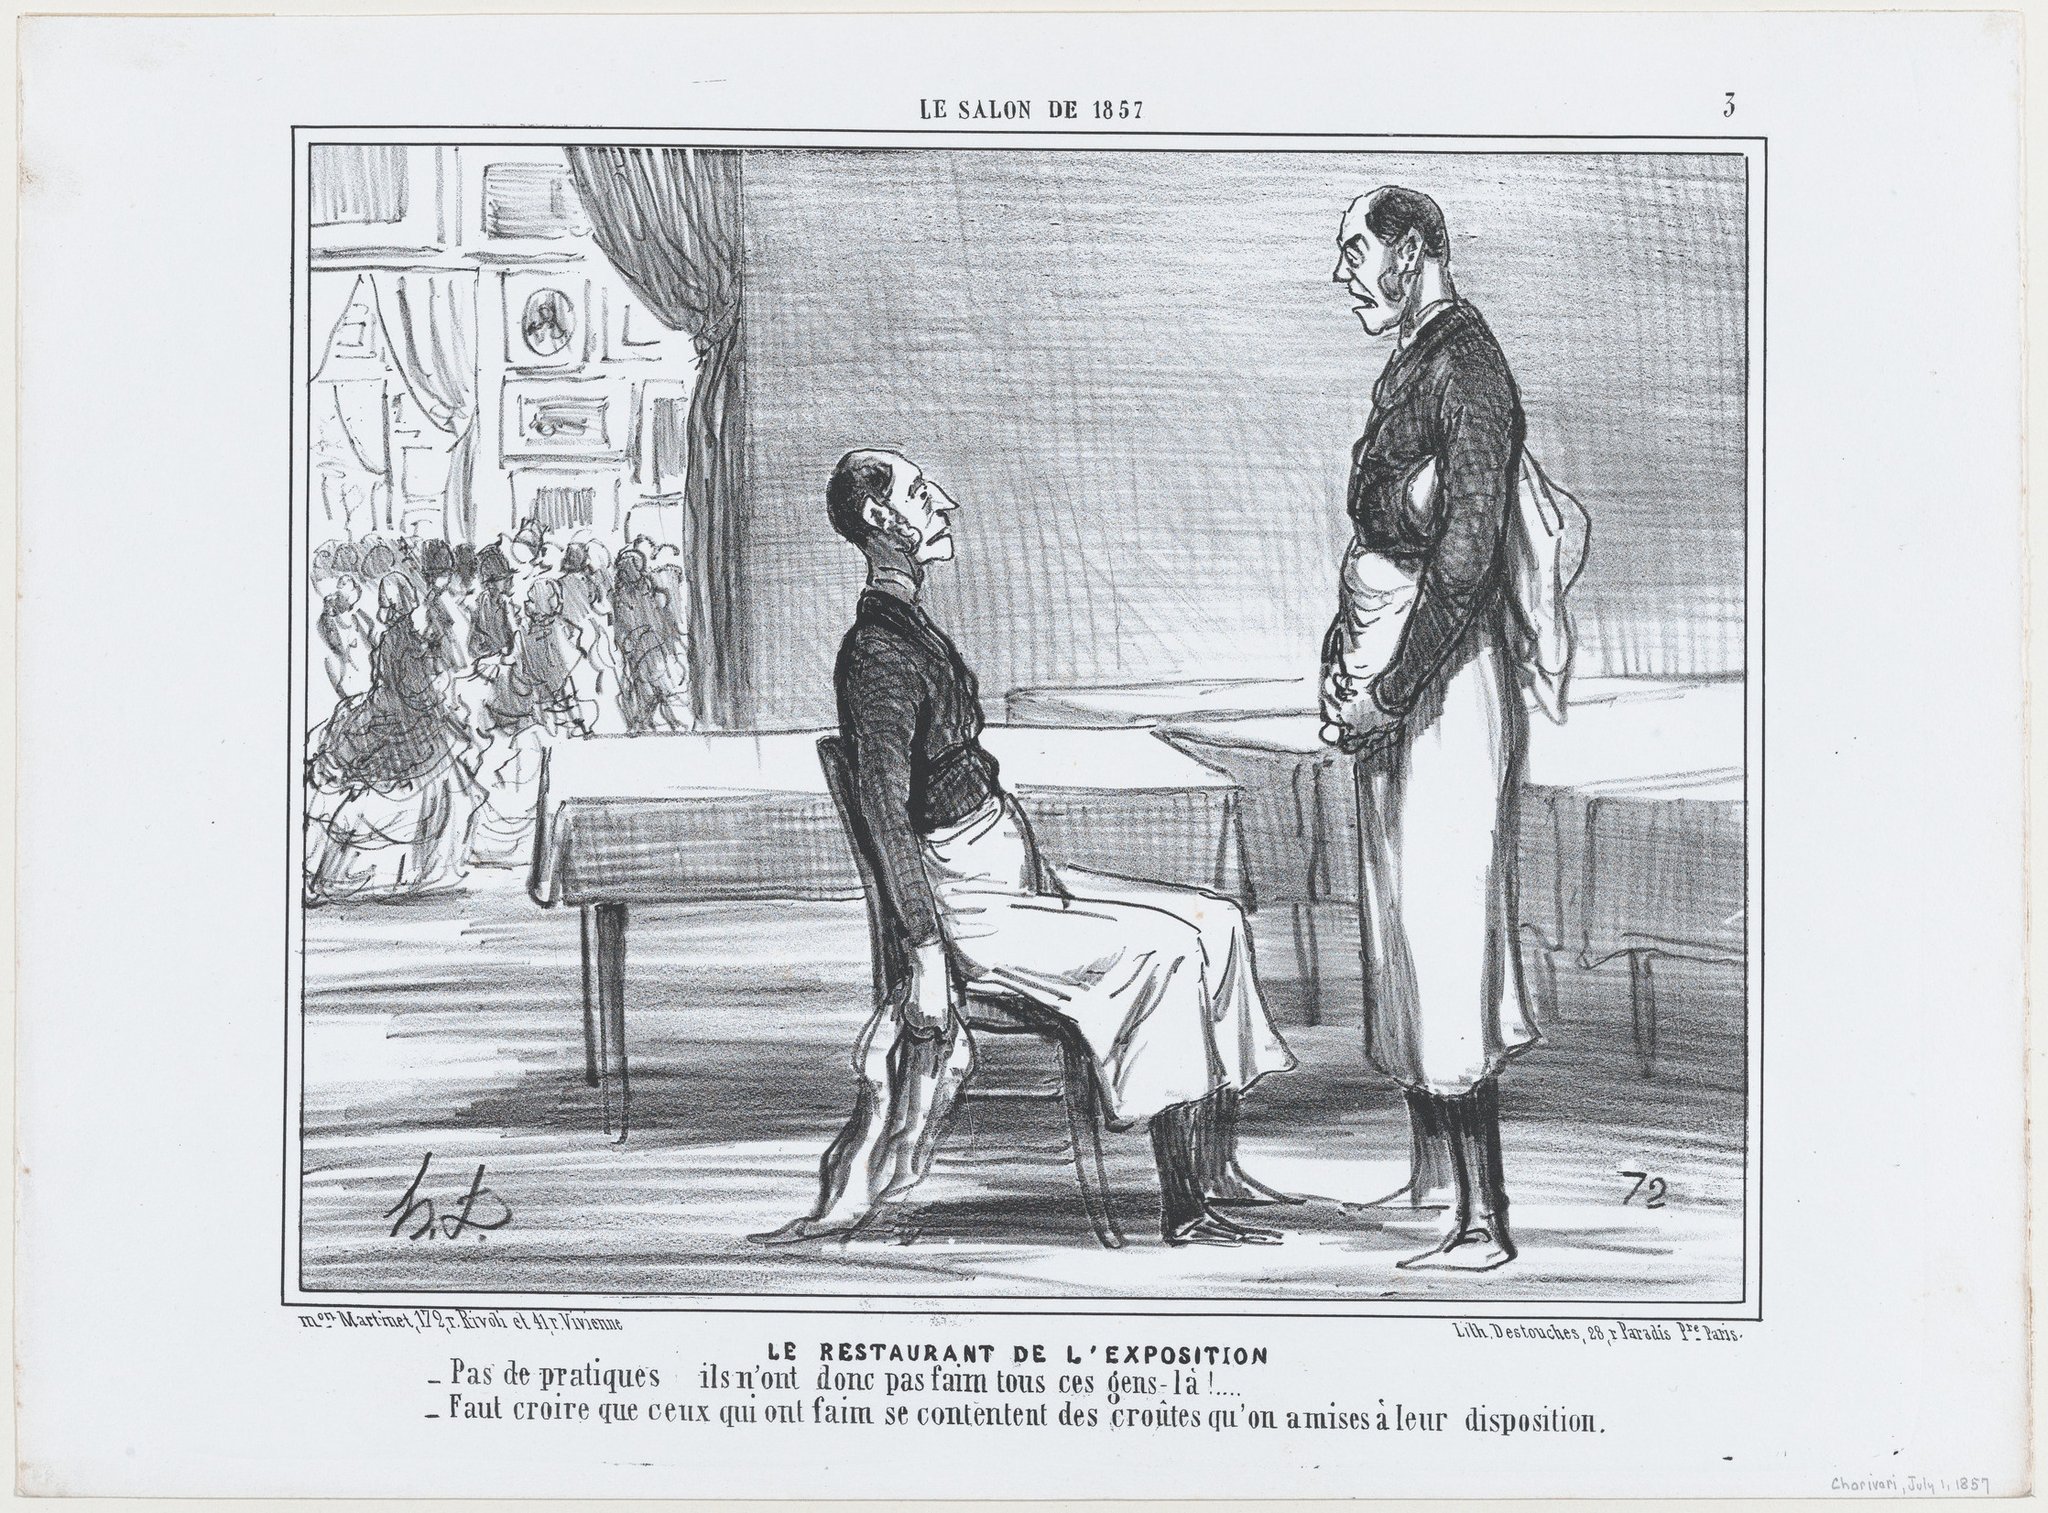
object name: print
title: Le Restaurant de L'Exposition, from Le Salon de 1857, published in "Le Charivari"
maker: honoré daumier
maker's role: artist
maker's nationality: french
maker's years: 1808-1879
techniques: lithograph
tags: men,tables